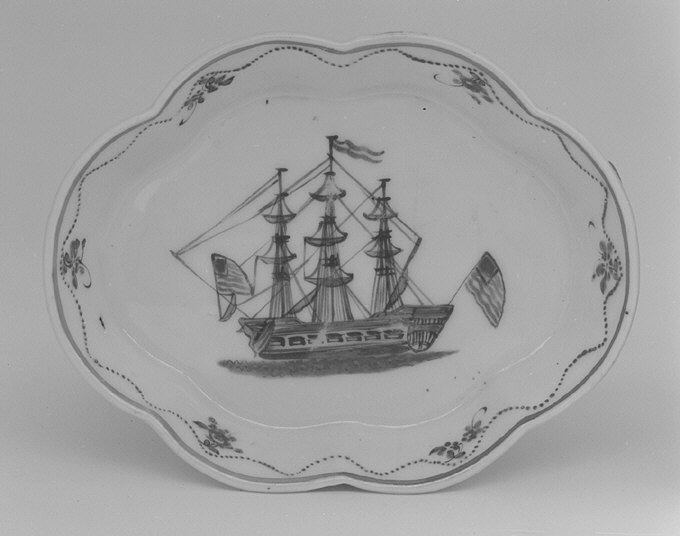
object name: spoon tray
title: Spoon tray (part of a service)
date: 1795-1800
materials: hard paste porcelain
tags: flags,ships